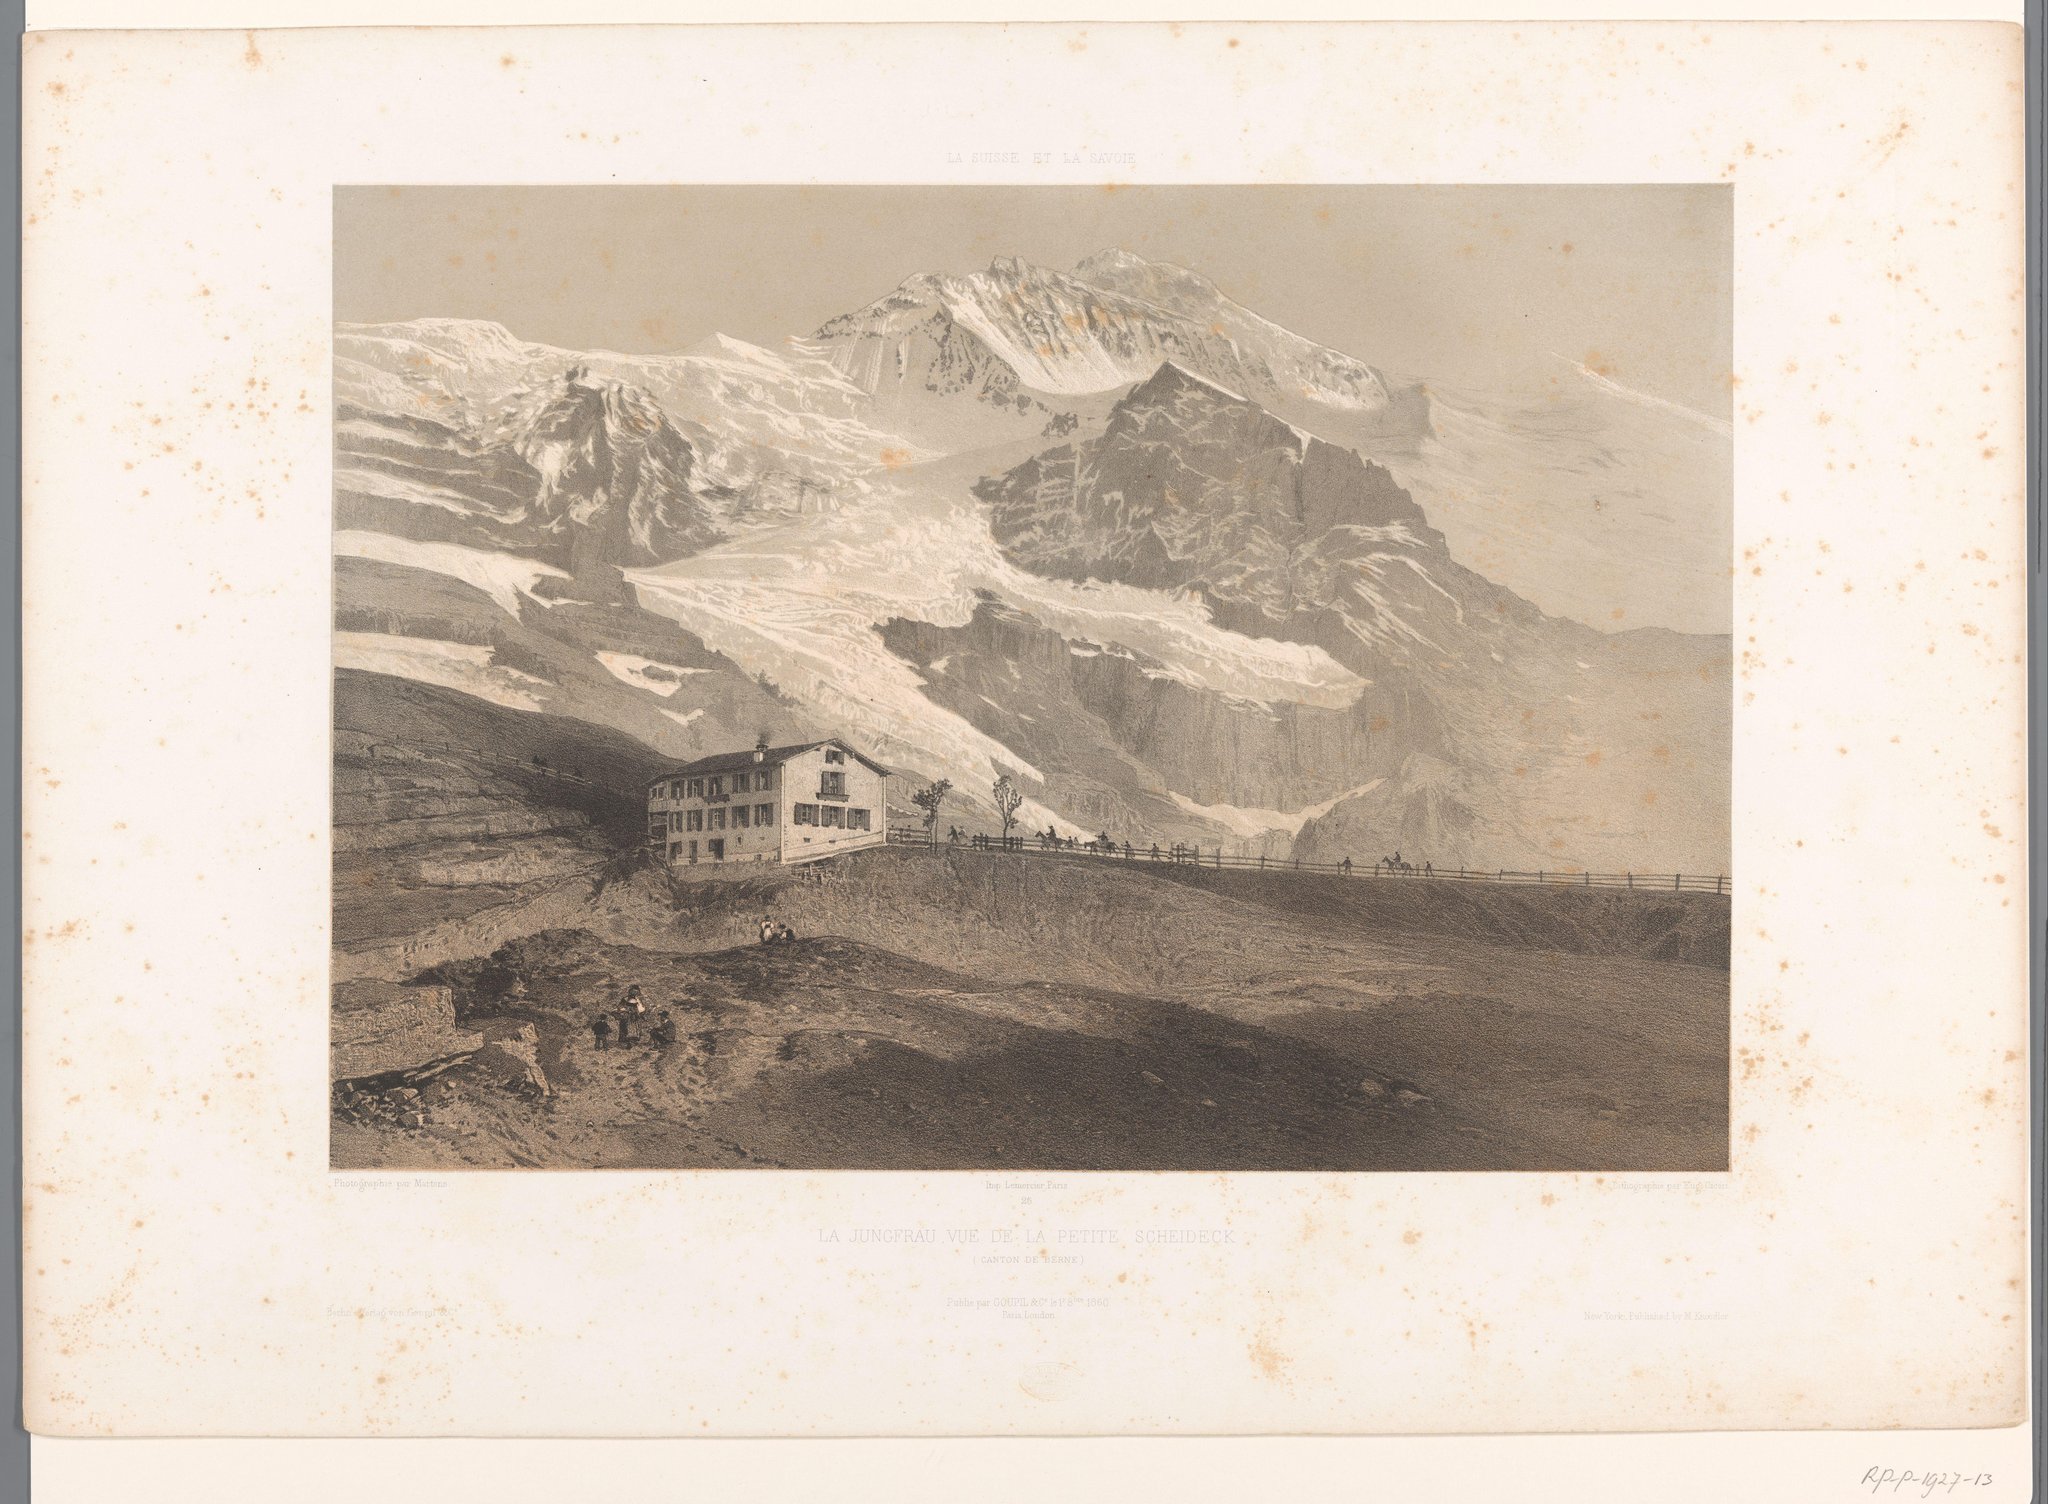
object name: print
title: Zicht op de Jungfrau vanaf de Kleine Scheidegg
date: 1859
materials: paper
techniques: iris print, lithograph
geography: berlin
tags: mountain-range, snow peaks (+ landscape with figures, staffage)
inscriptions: check stamp: Lugt 1090